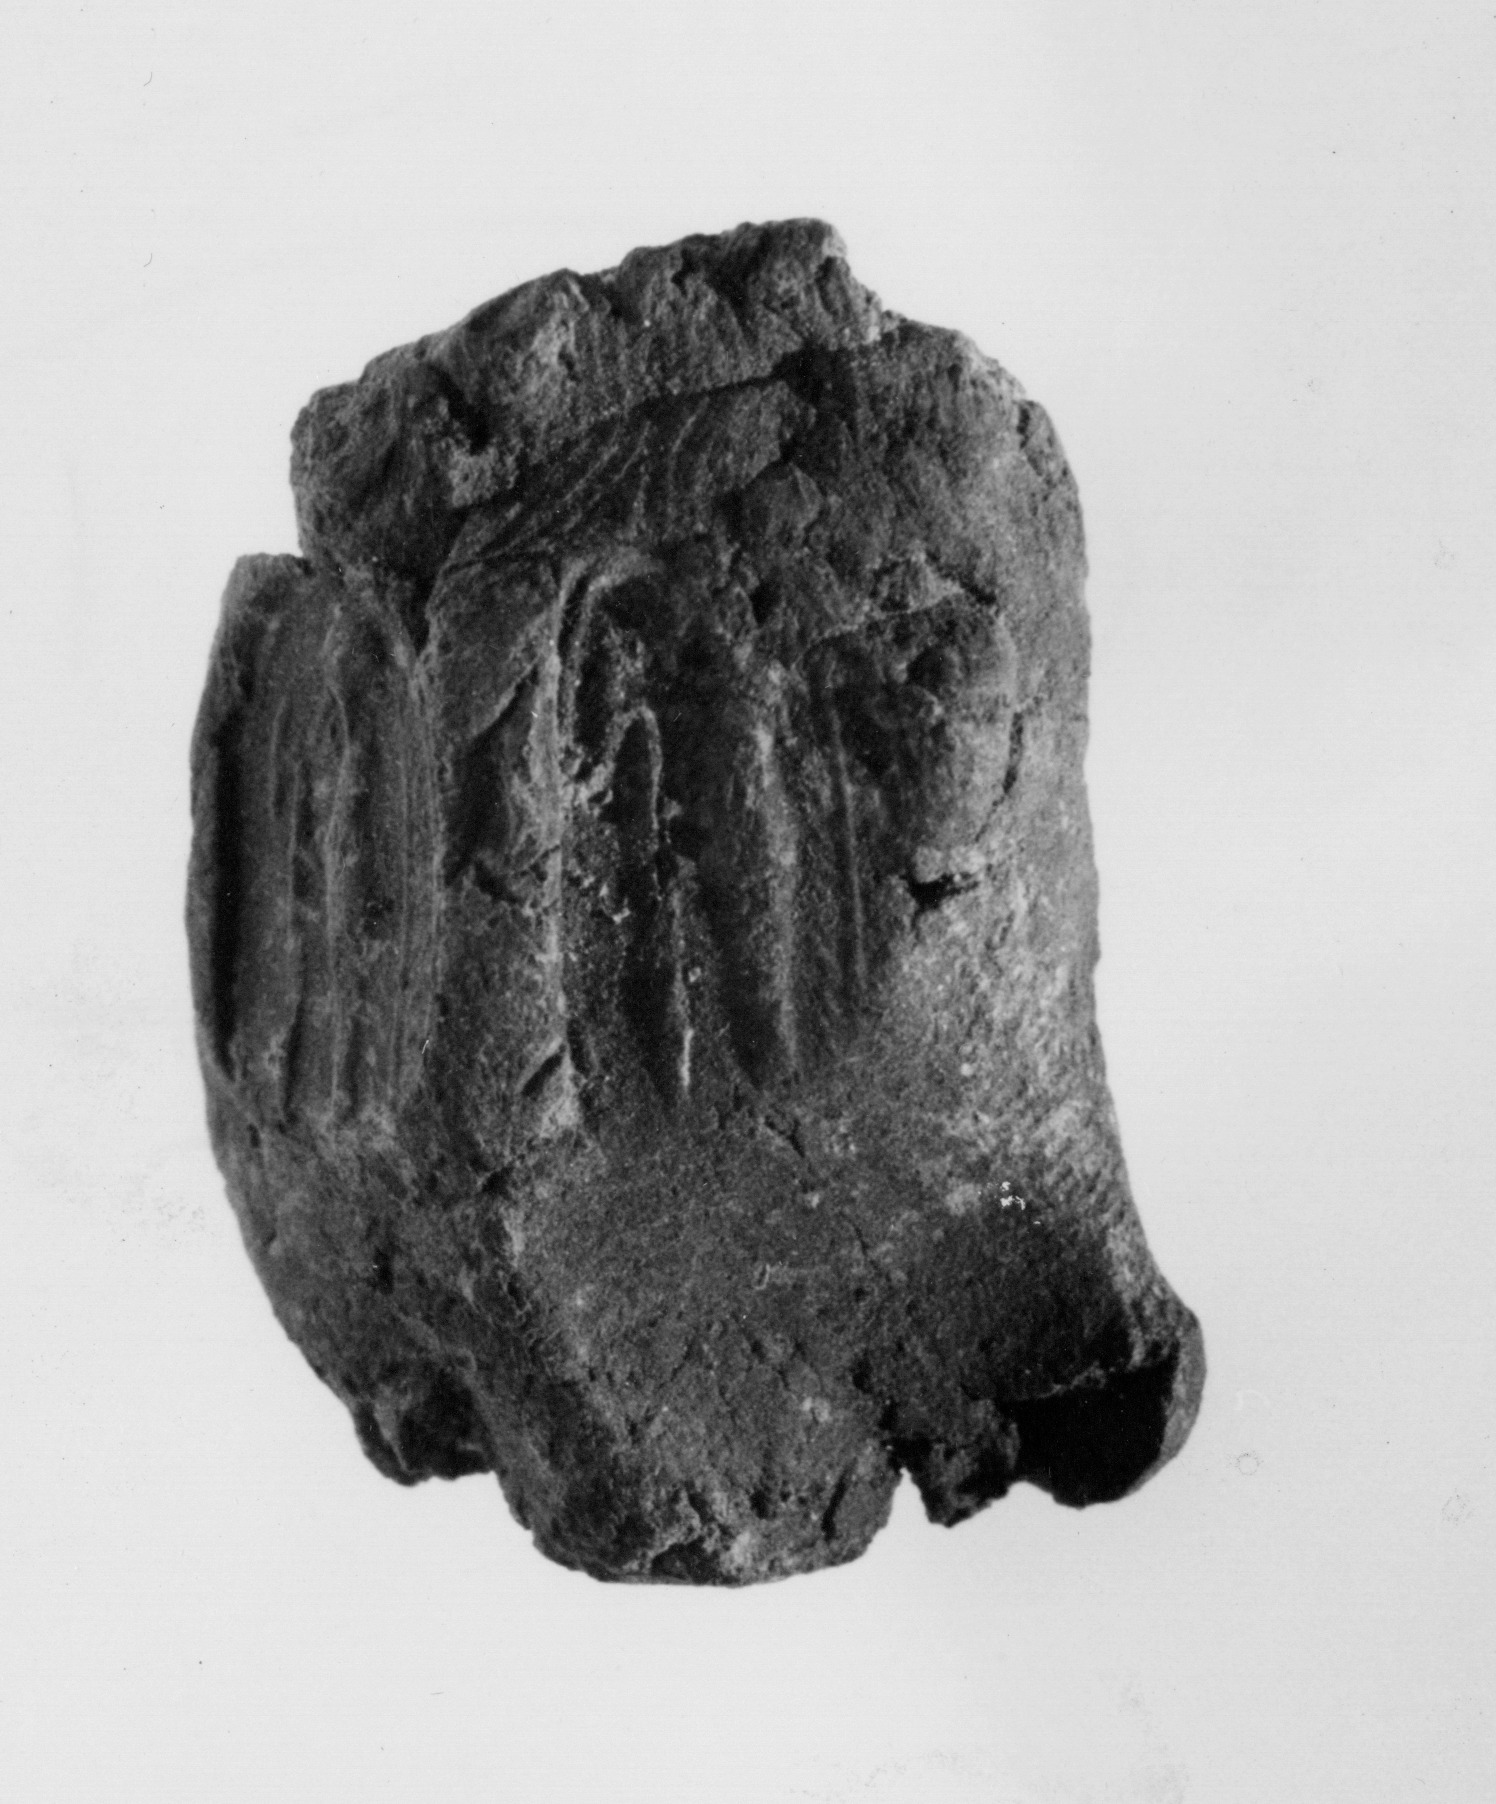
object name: sealing, ptah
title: Document Sealing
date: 1390-1352 BCE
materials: mud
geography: egypt